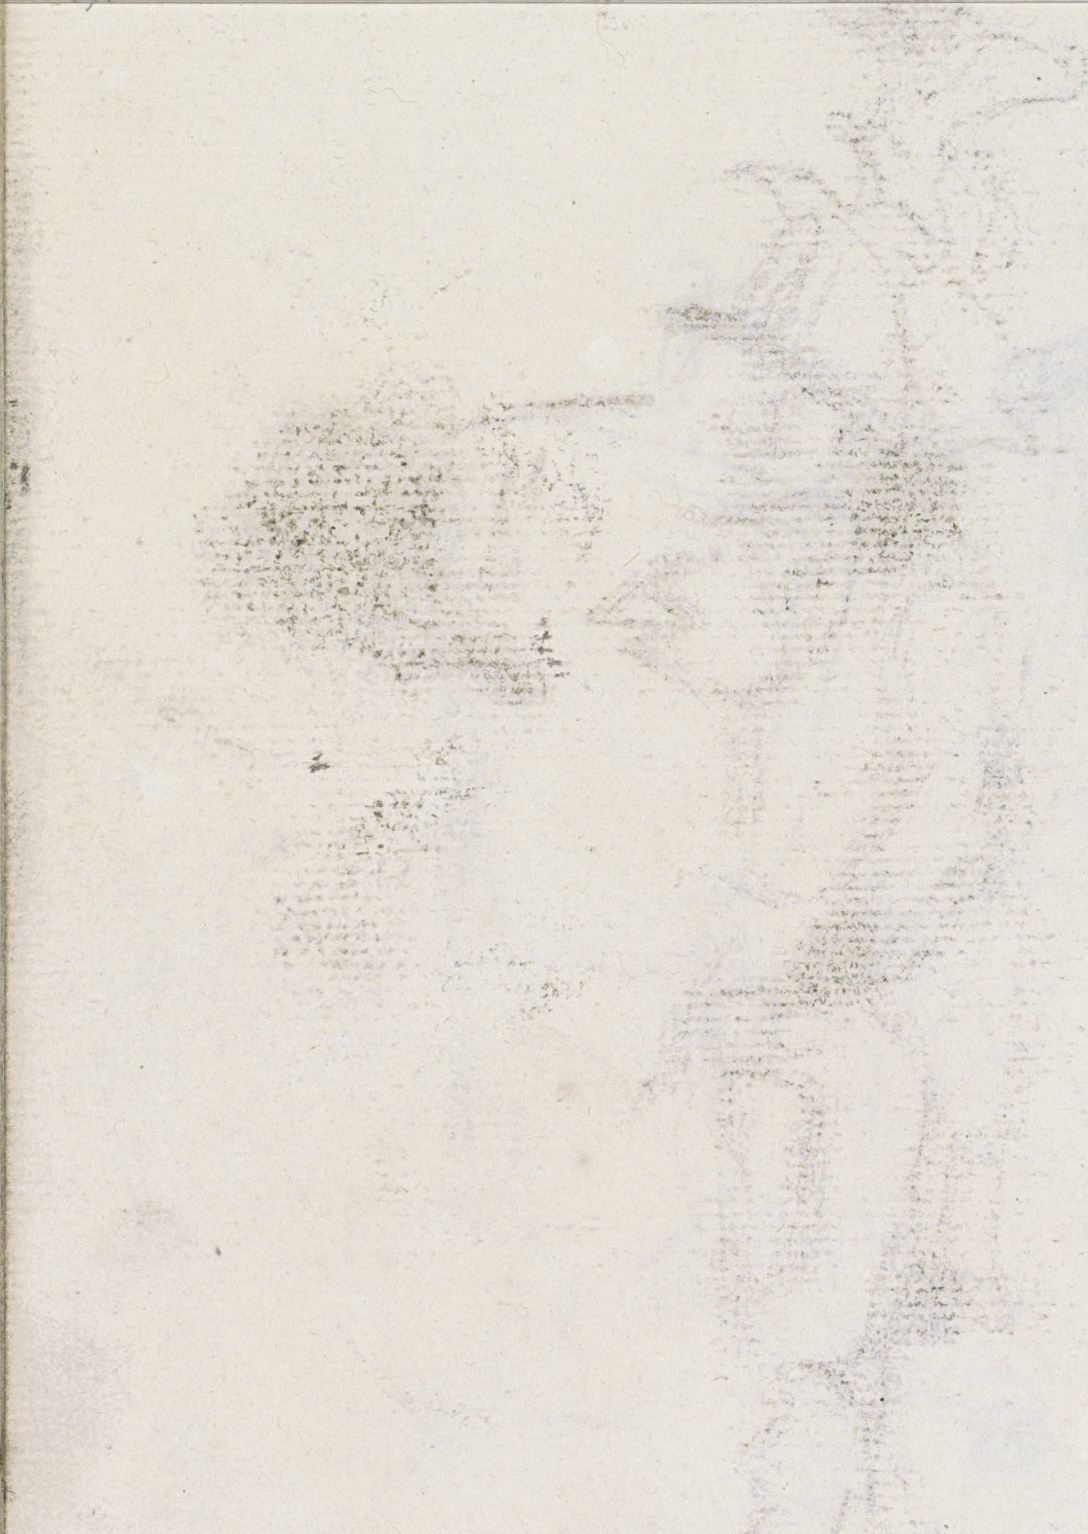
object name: sketchbook leaf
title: Abklatsch van de krijttekening op blad 3 recto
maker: isaac israels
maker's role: draughtsman, painter, print maker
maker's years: 1865-1934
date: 1886-1934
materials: paper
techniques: printmaking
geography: amsterdam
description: Blad 2 verso uit schetsboek LV met 21 bladen.